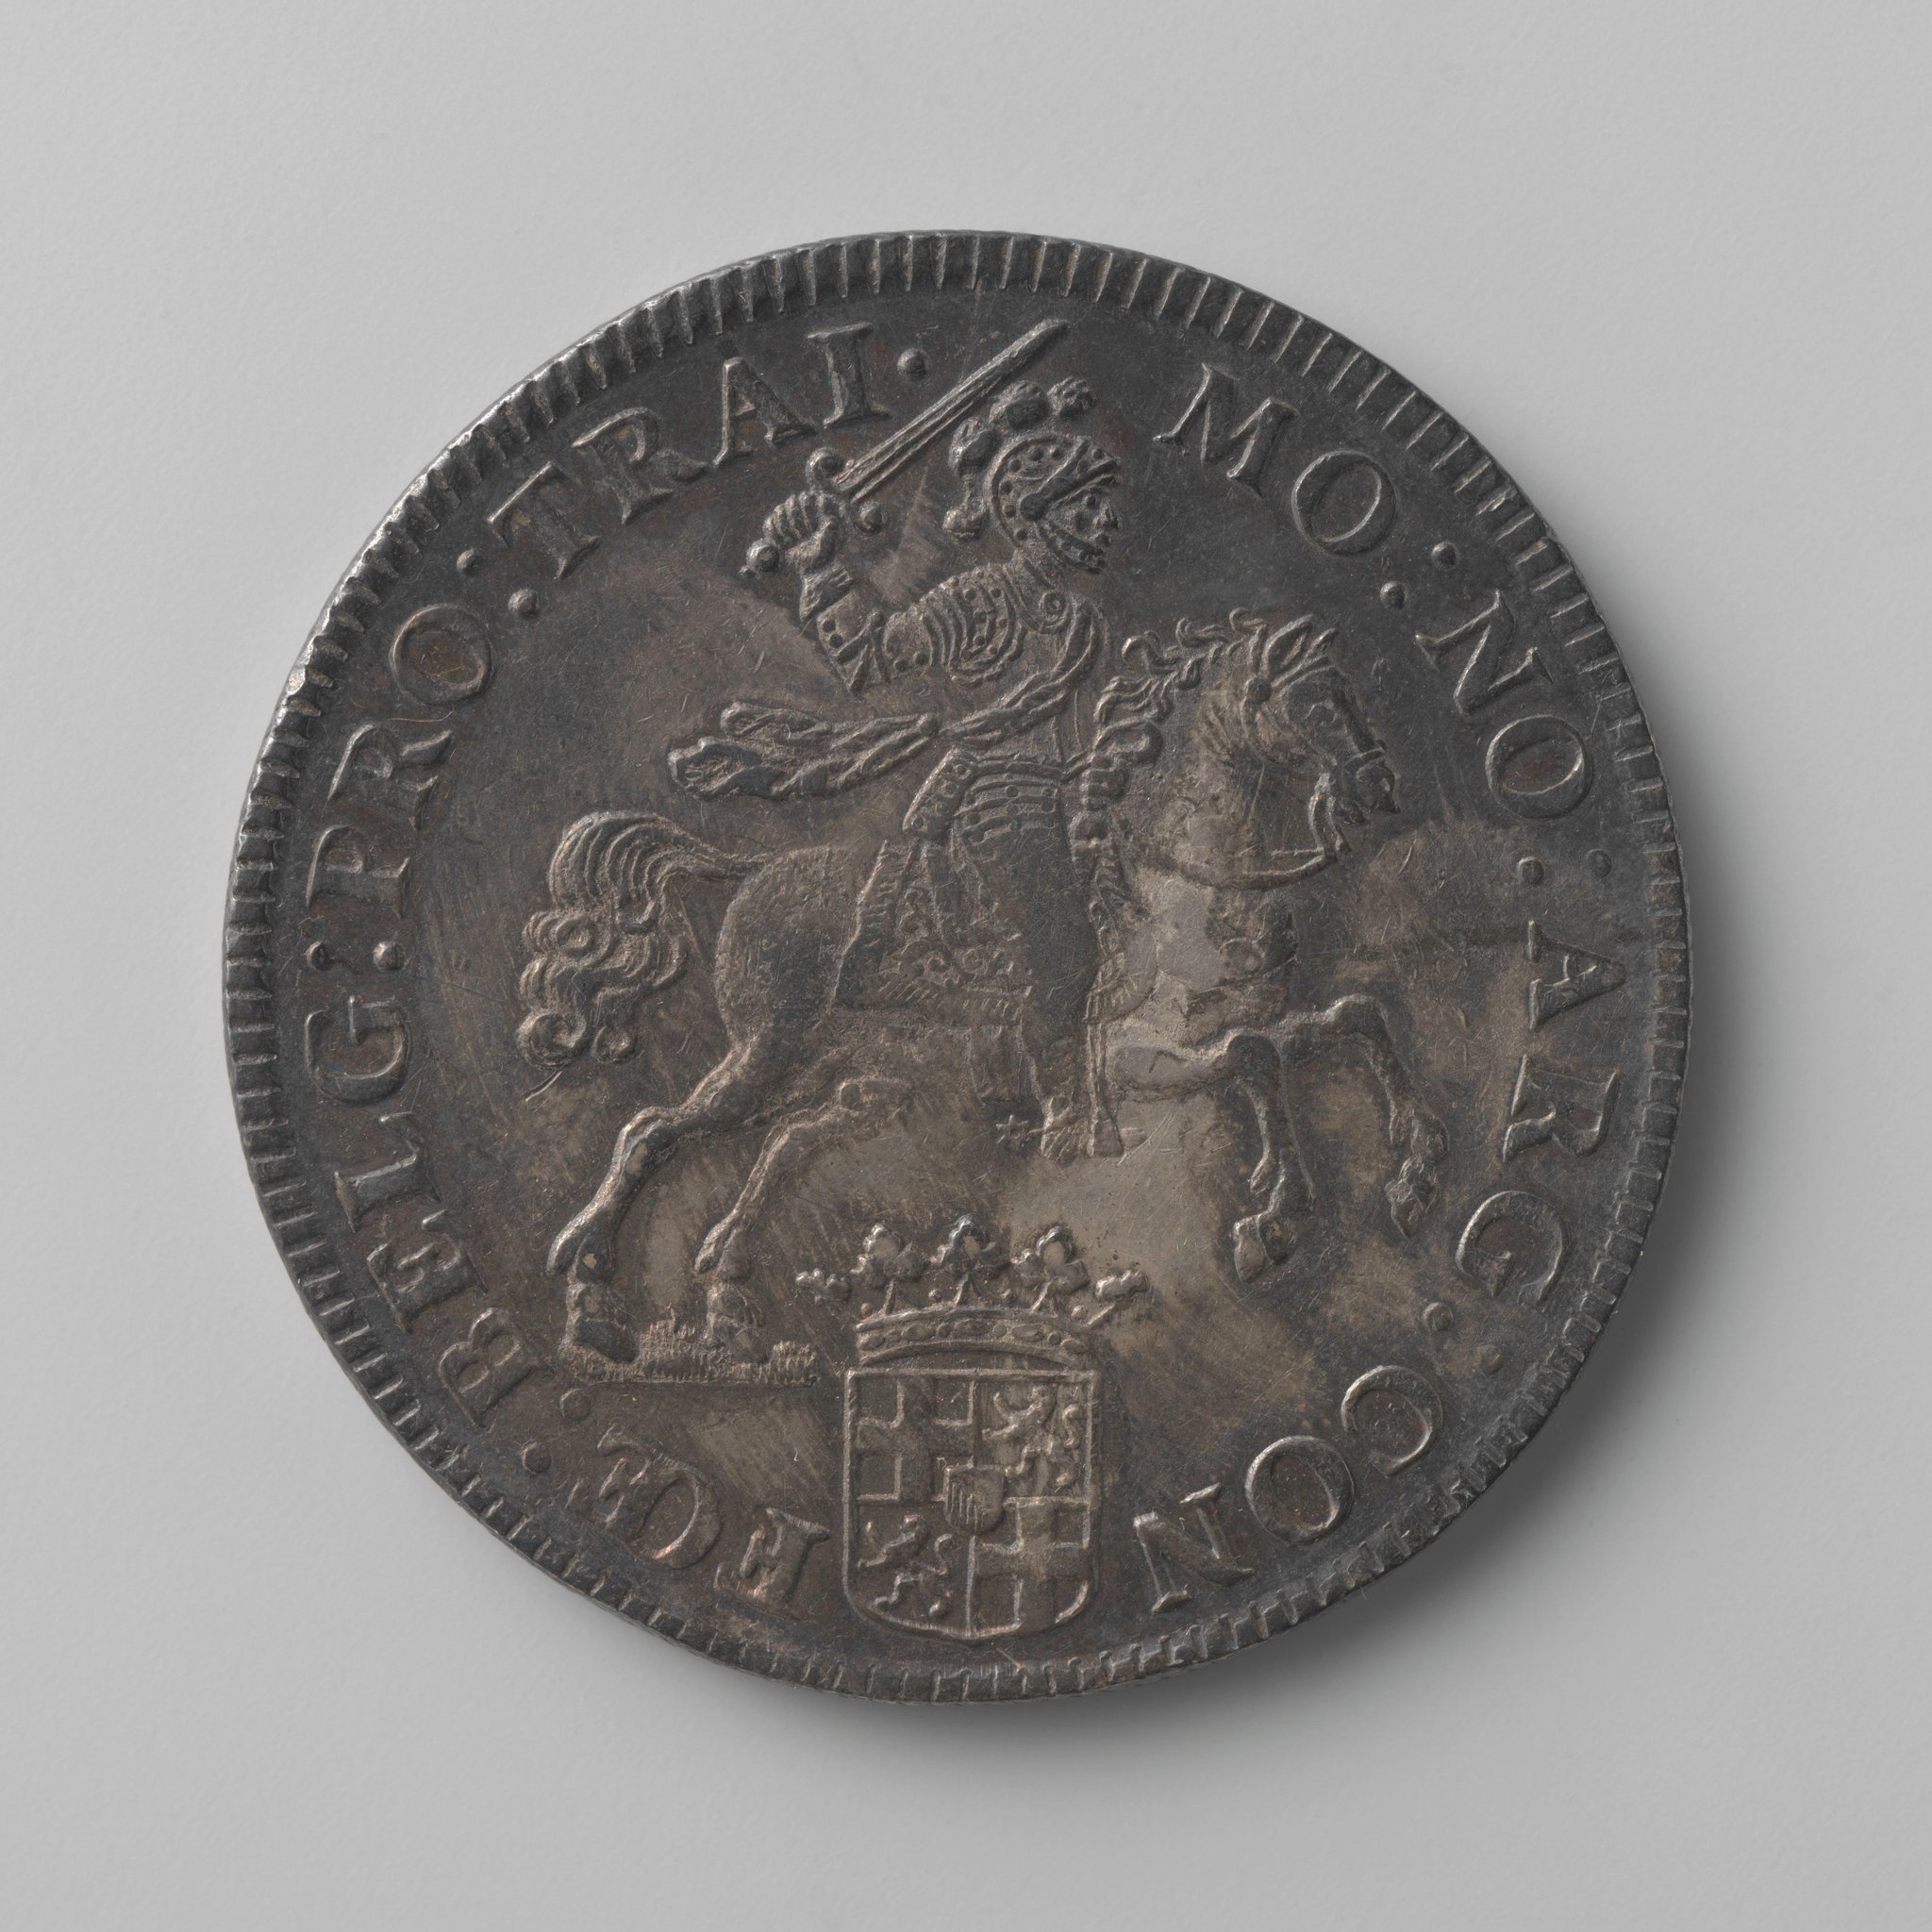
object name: coin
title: Utrechtse zilveren rijder, 1739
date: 1739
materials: silver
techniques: striking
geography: utrecht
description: Zilveren munt. Voorzijde: ridder te paard naar rechts met in rechterhand zwaard. Onder paard gekroond wapenschild van Utrecht. Keerzijde: door twee gekroonde leeuwen gehouden generaliteitswapenschild. Daaronder in cartouche jaartal. Kabelrand.